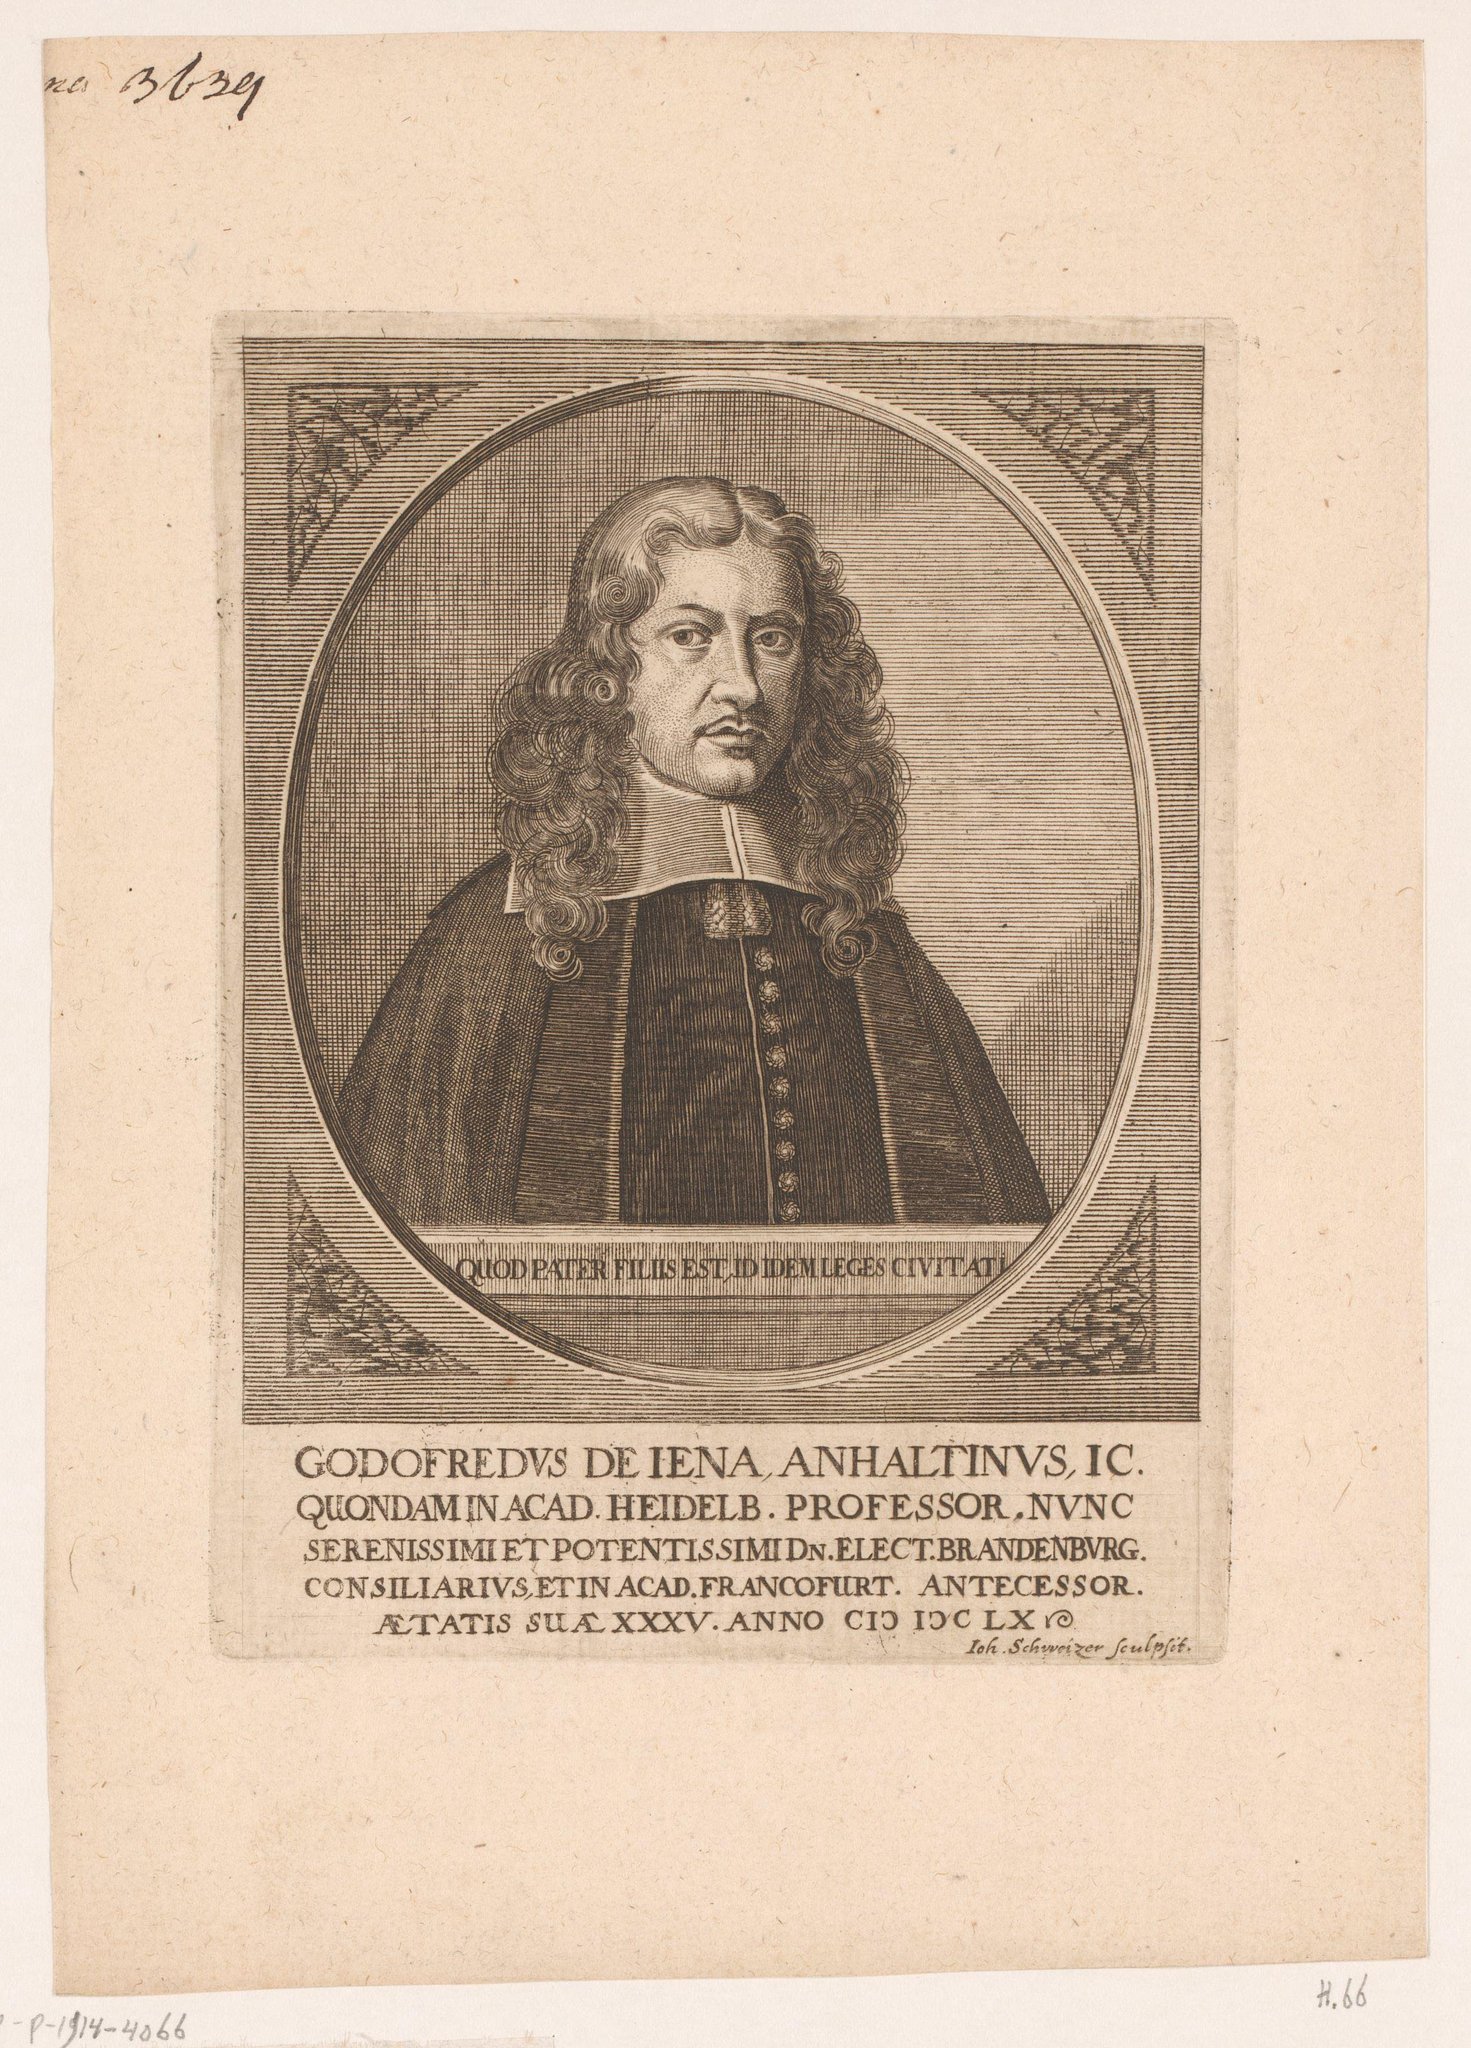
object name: print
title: Portret van Gottfried von Jena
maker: johann schweizer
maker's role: print maker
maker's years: 1625-1670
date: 1660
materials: paper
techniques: engraving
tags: historical persons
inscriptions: collector's mark: Lugt 2228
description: Prent ook gebruikt in: Berger, Hieronymus. Parnassus Heidelbergensis (...). Frankfurt am Main: Hieronymus Berger, 1660.